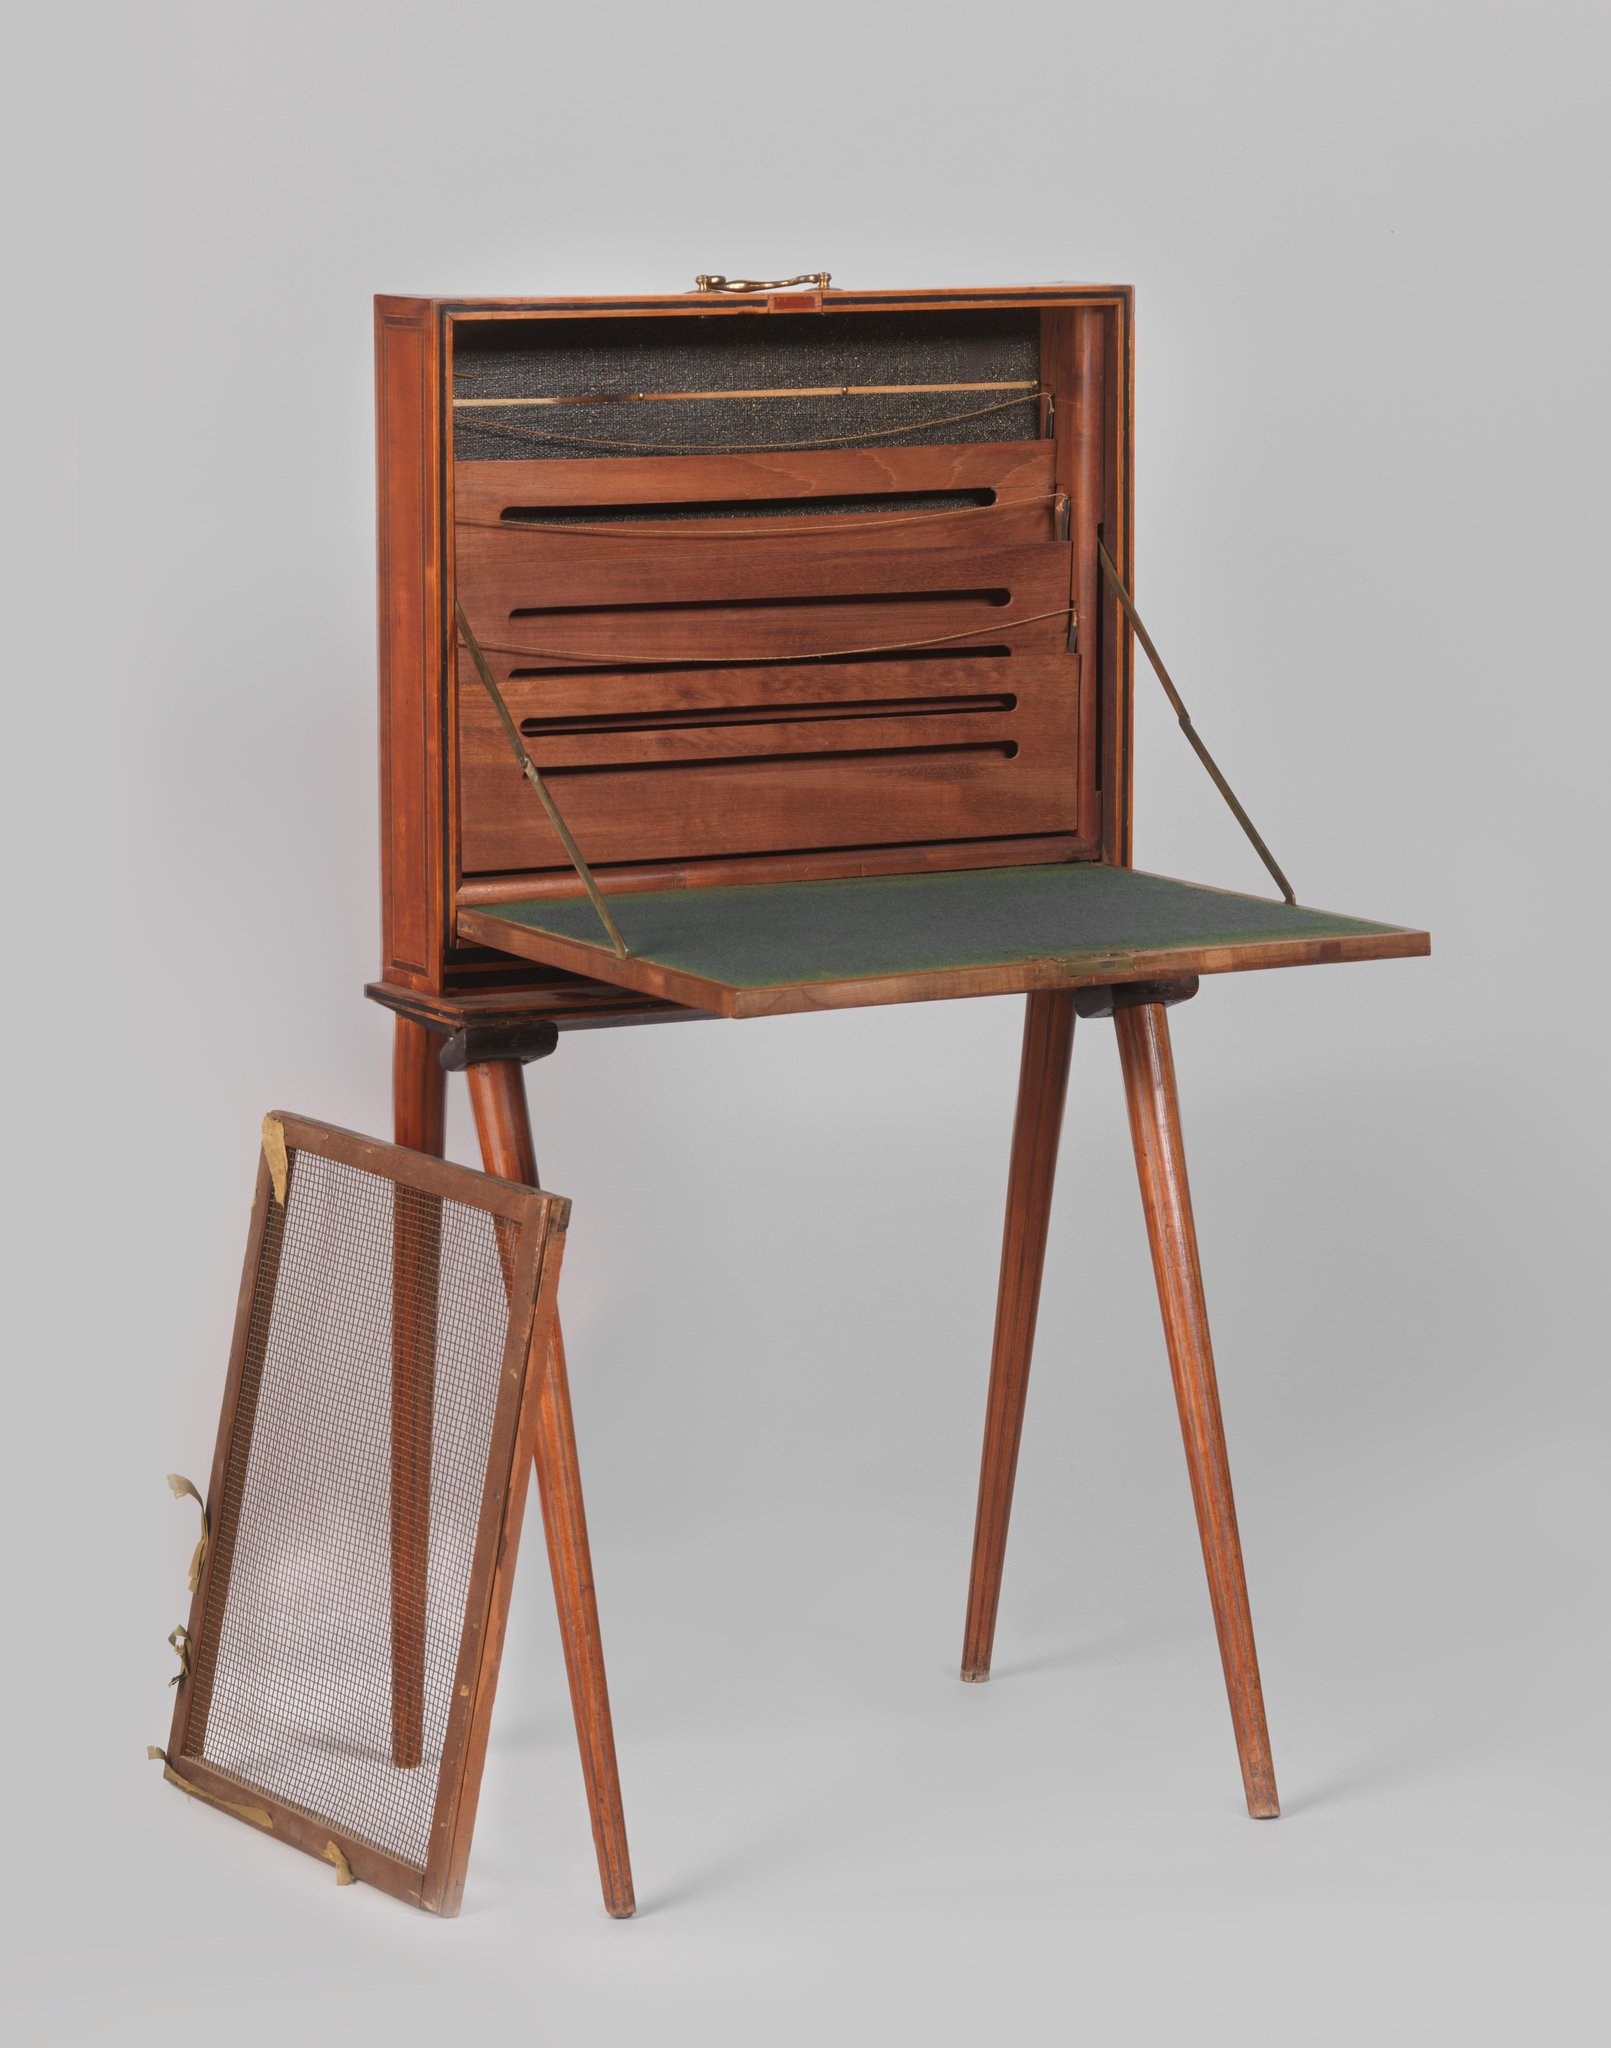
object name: schilderskist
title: Schilderskist van satijnhout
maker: Anonymous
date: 1780-1795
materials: wood, lacquer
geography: netherlands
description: Painter's box. Oak, veneered with various woods, inlaid with a Japanese (?) lacquer panel. Netherlands, c. 1780 - 1795. On loan from the Koninklijk Oudheidkundig Genootschap.